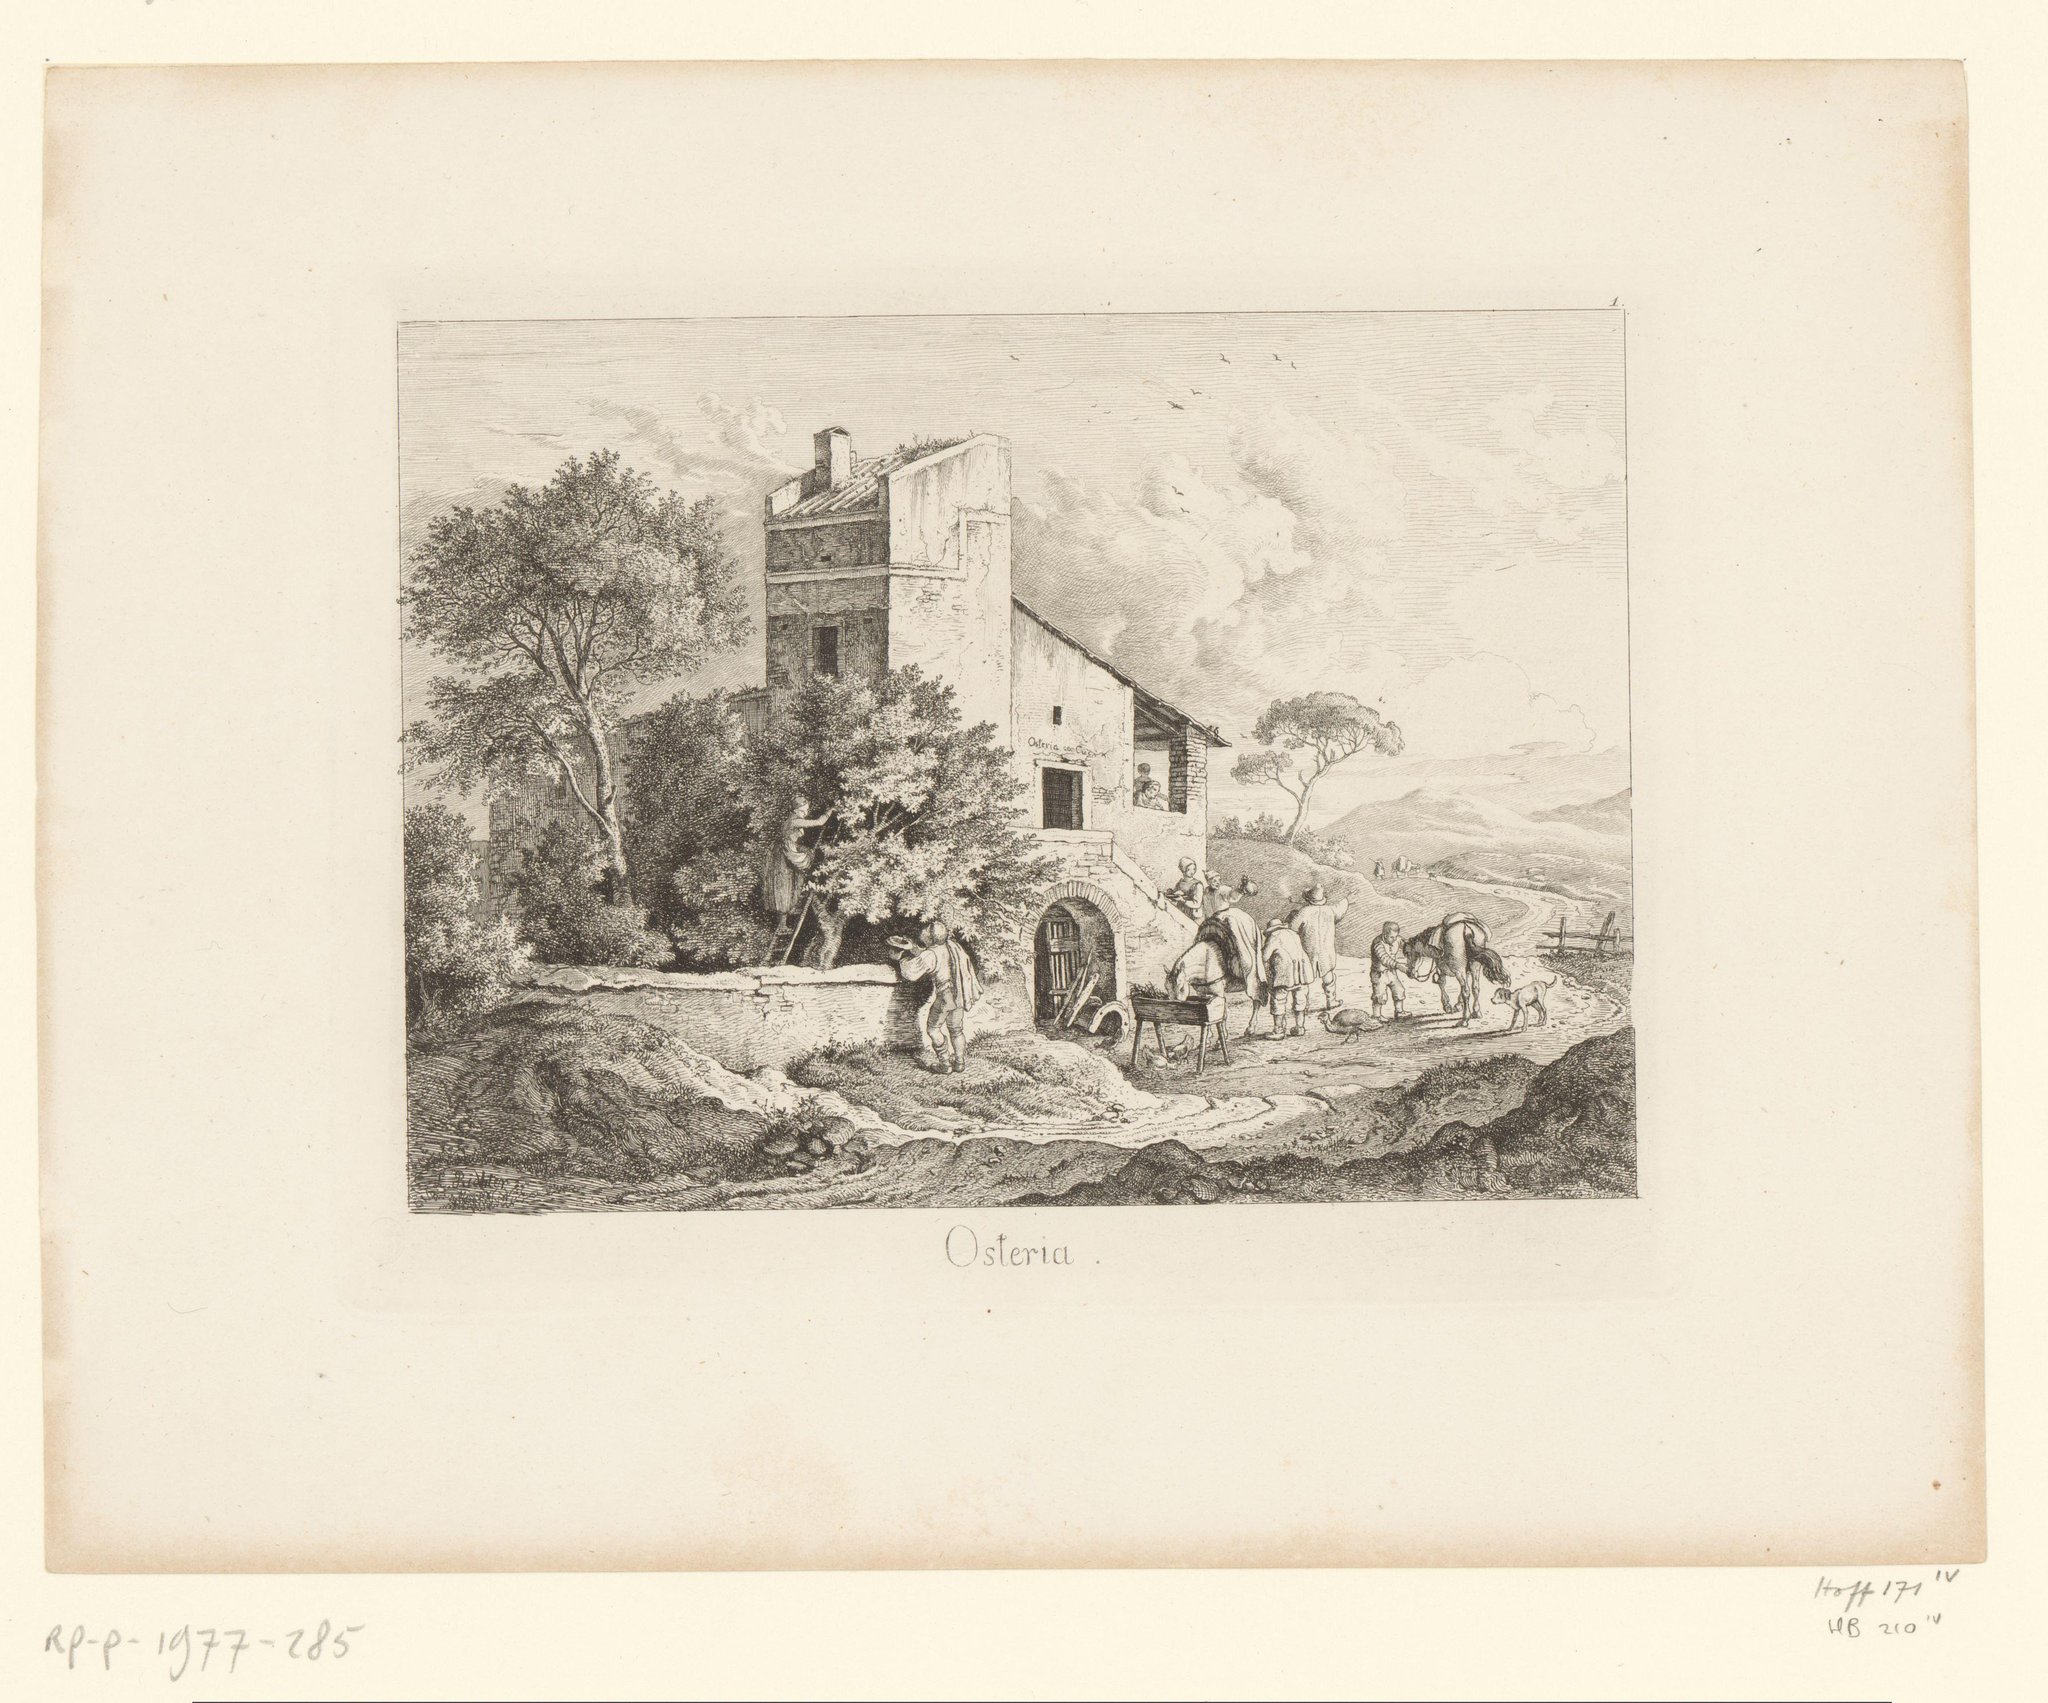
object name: print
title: Gezicht op een osteria met reizigers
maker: ludwig richter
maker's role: painter, print maker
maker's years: 1803-1884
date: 1831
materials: paper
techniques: etching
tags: landscapes, inn, coffee-house, public house, etc.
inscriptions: collector's mark: Lugt 2228, collector's mark: Lugt 2760